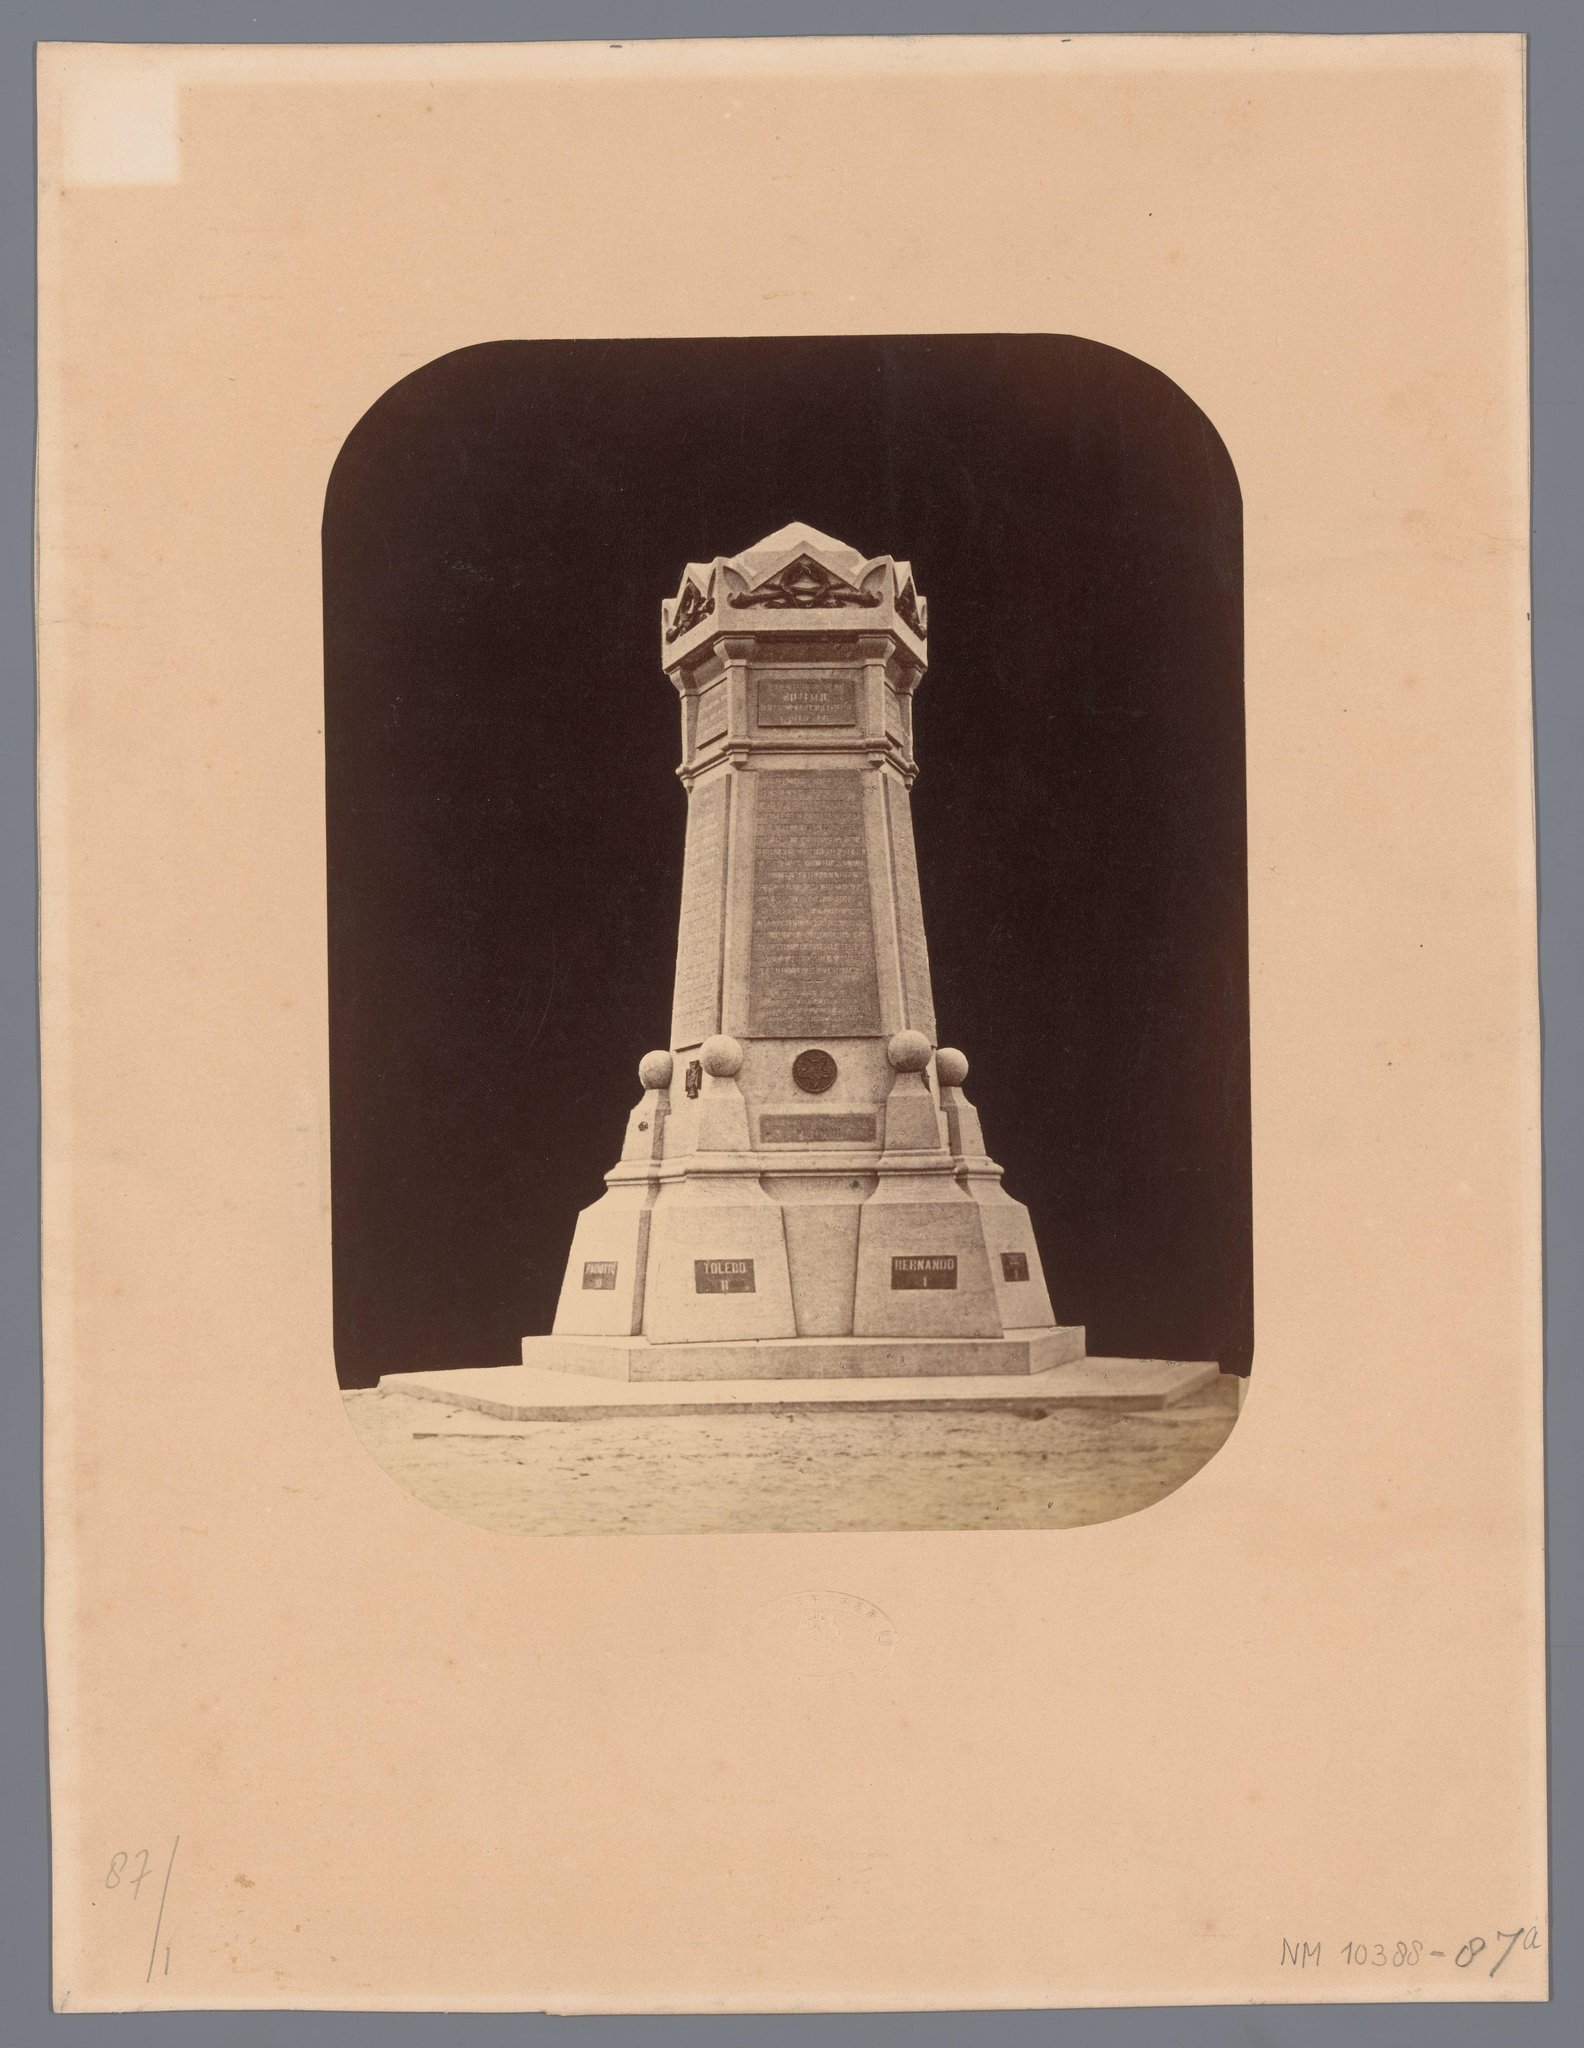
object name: photograph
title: Monument van de gevallenen bij de Citadel van Antwerpen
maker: m. vermeer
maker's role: fotograaf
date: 1874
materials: cardboard, paper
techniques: photography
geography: the hague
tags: citadel van antwerpen (19e eeuw), strijd om de citadel van antwerpen (1832)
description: Foto, met afgeronde hoeken, op kaarten geplakt, (v.h. monument van de gevallenen bij citadel Antwerpen. Gemrkt; m.o.: reliëfstempel fotoatelier.